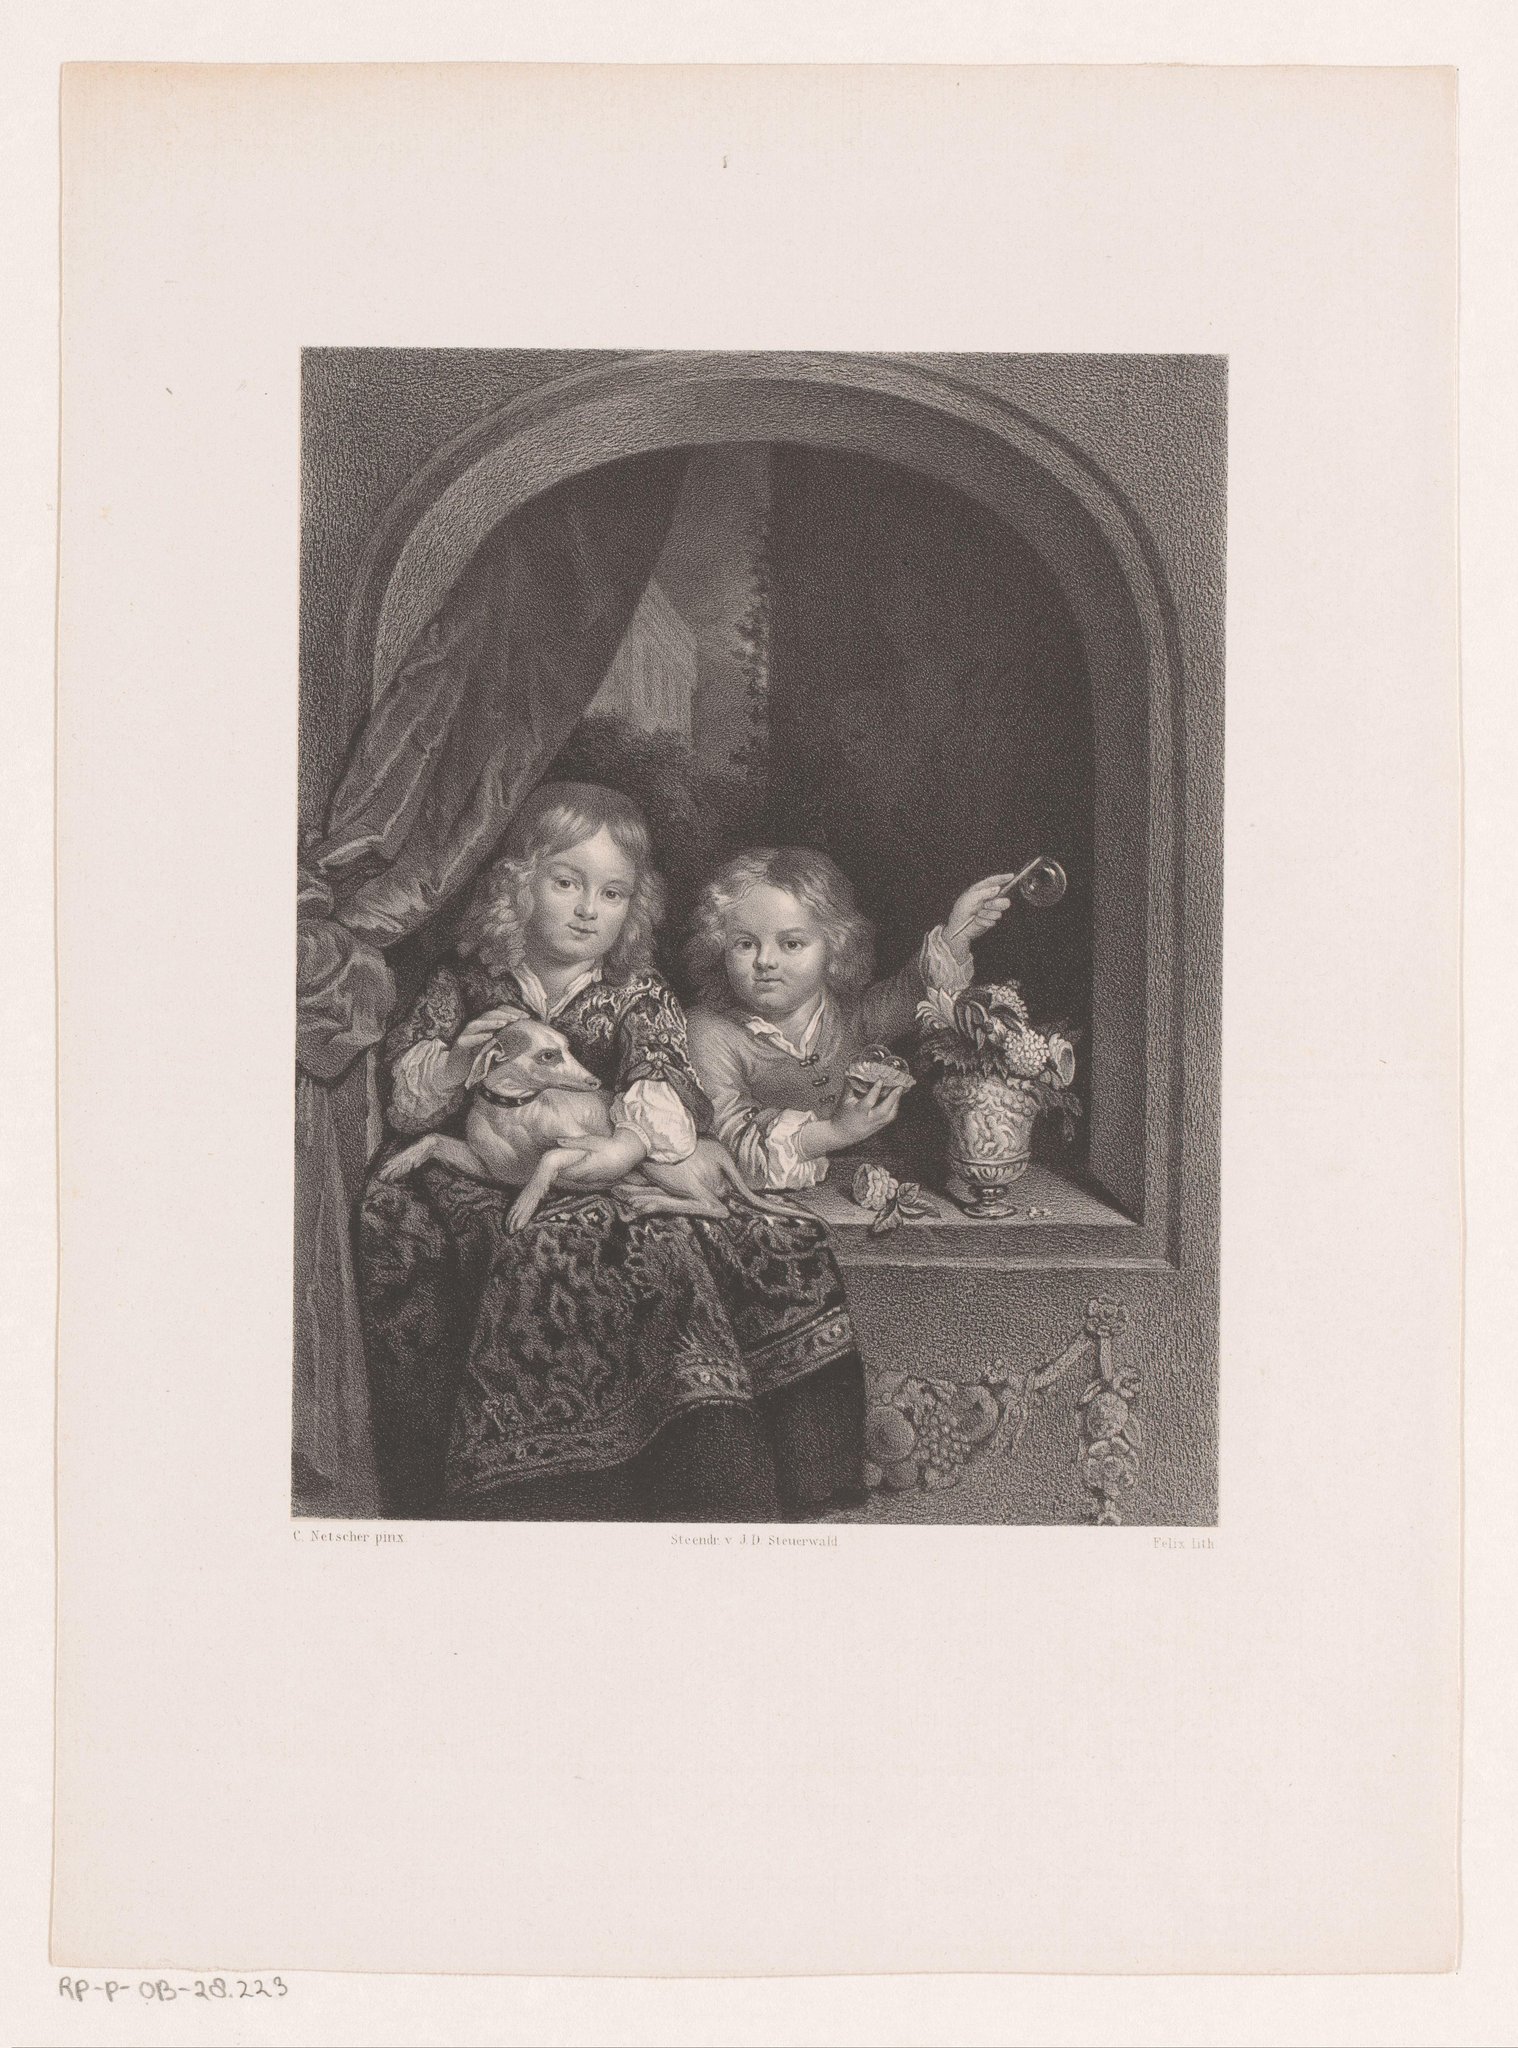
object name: print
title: Twee kinderen in een venster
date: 1845-1863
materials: paper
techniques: lithograph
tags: bubble-blowing (children's games and plays), child, open window, dog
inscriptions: collector's mark: Lugt 2228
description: Een kind is bezig bellen te blazen. Het andere kind heeft een hond op schoot. In het venster staat een vaas met bloemen.